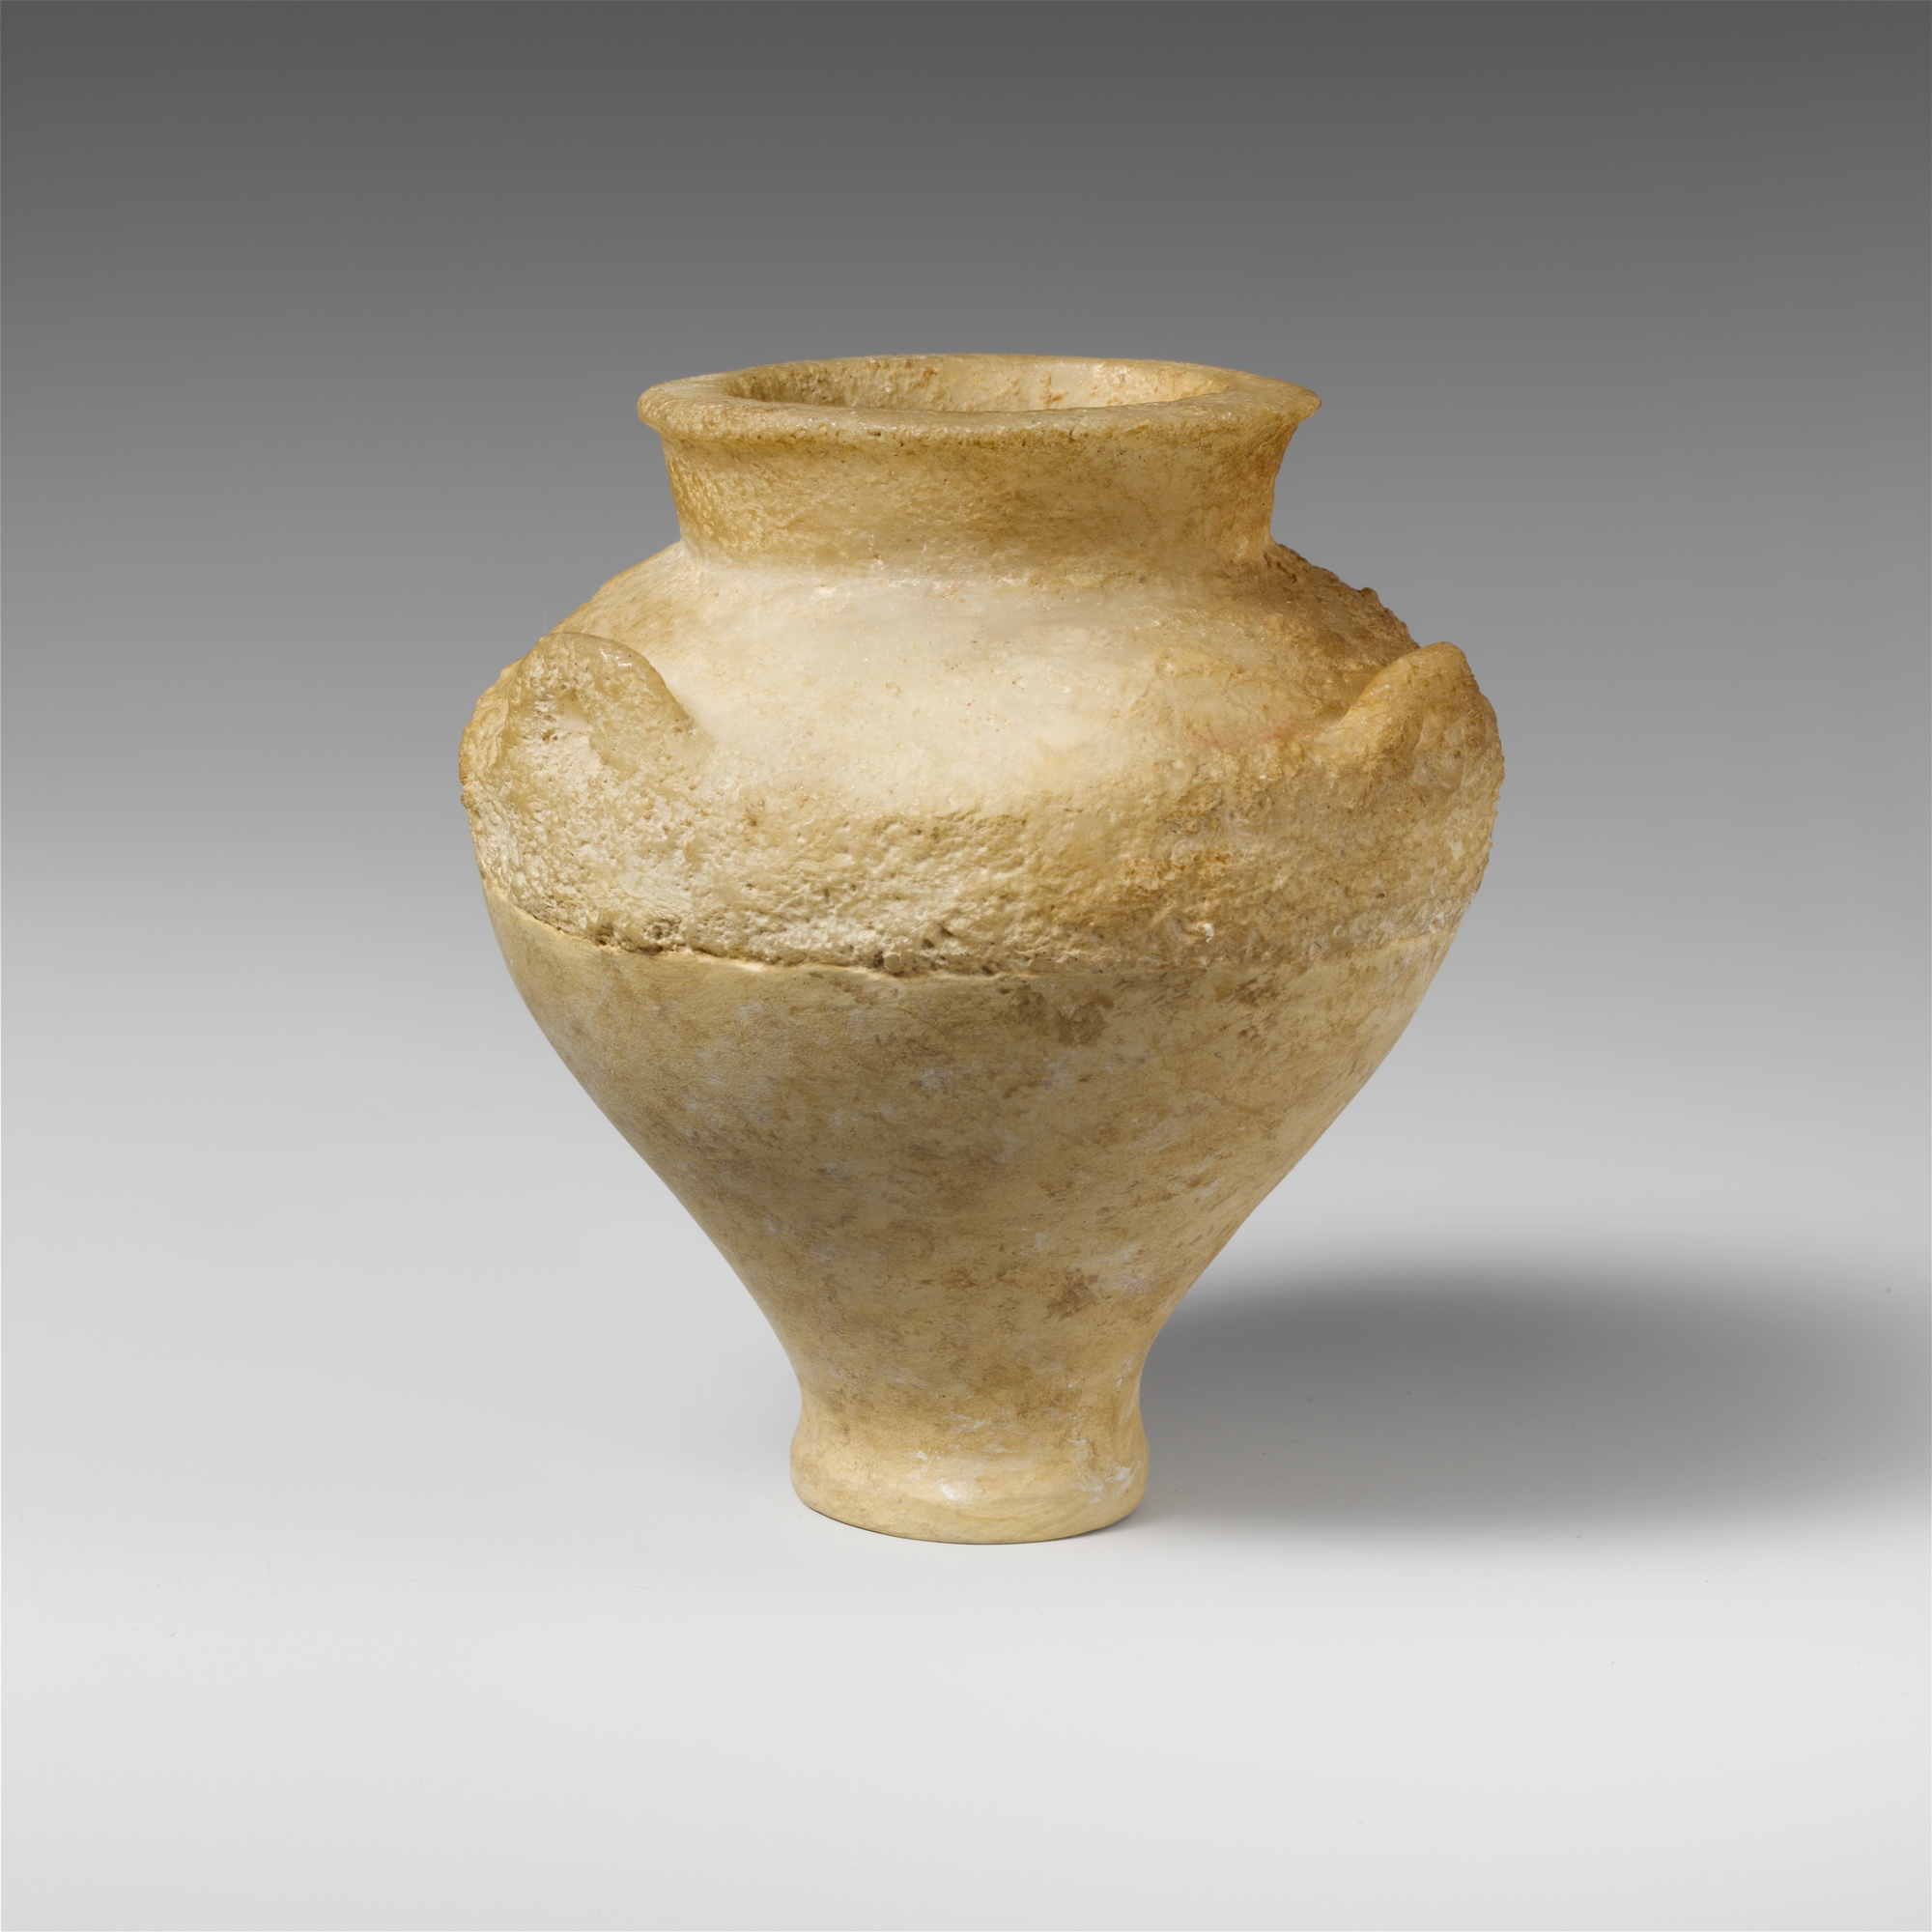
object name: vase, pear shaped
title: Miniature alabaster pithoid jar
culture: cypriot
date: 1400-1050 BCE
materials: gypsum